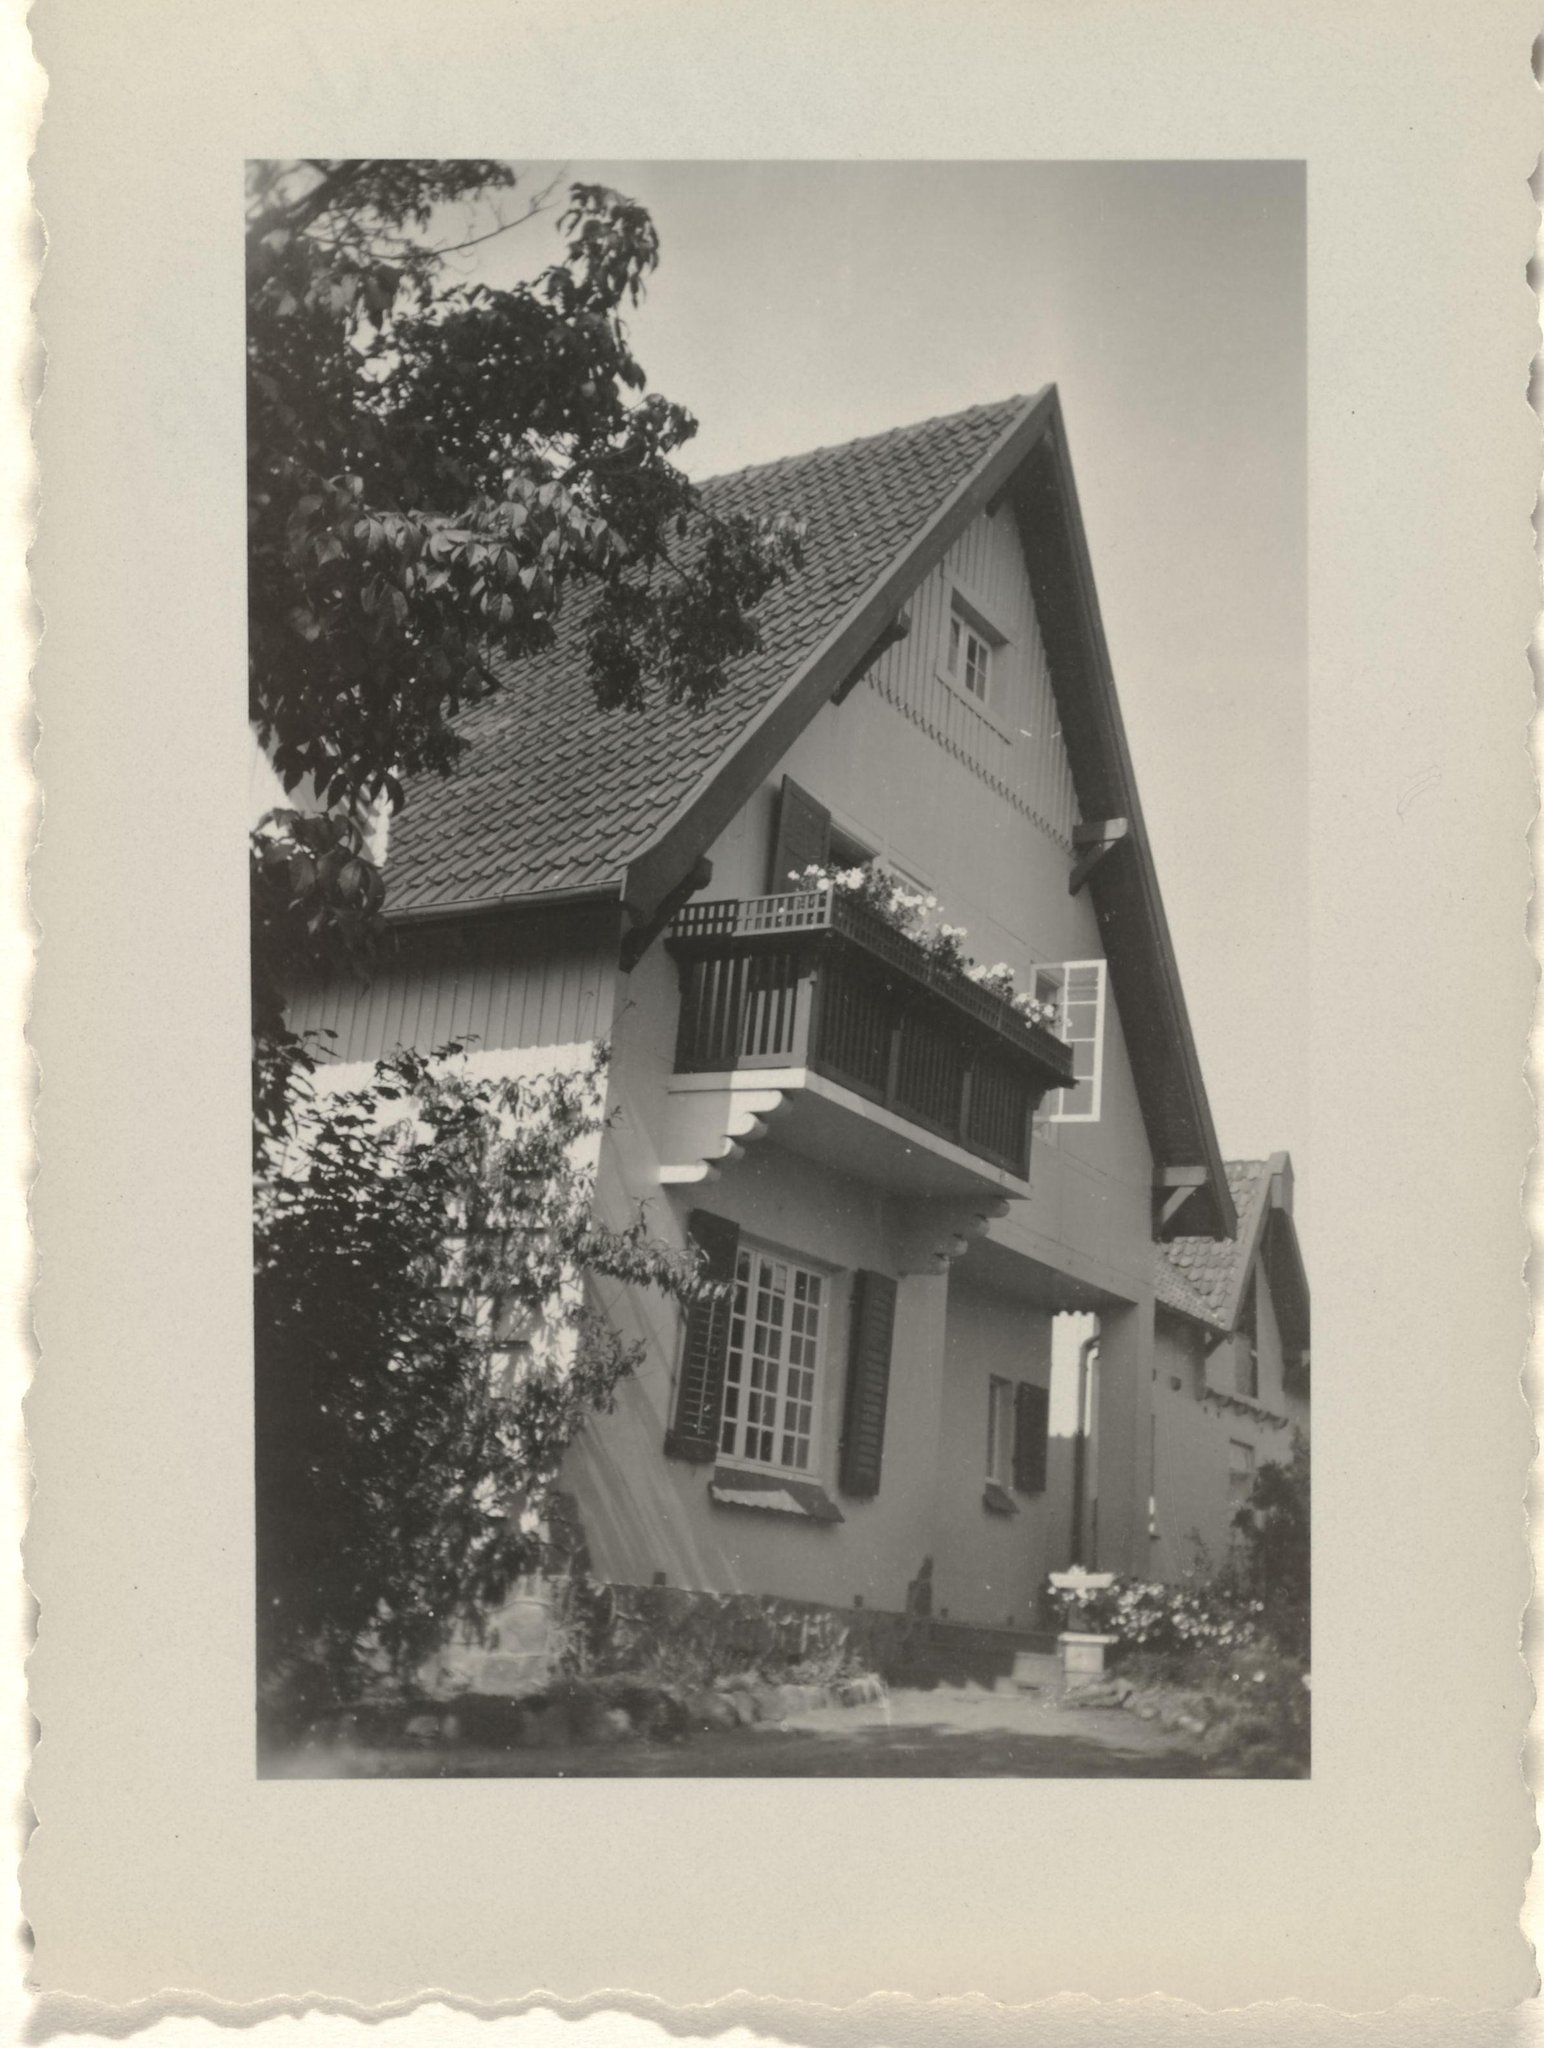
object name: photograph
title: Huis Fahrenkamp, van de zijkant, met een balkon met daarop bloemen geplaatst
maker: Anonymous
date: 1934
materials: photographic support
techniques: gelatin silver print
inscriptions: date: ‘sept.34. Haus Fahrenkamp. (v. der Seite). 7’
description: Zicht op huis Fahrenkamp, van de zijkant, met een balkon met daarop bloemen geplaatst.